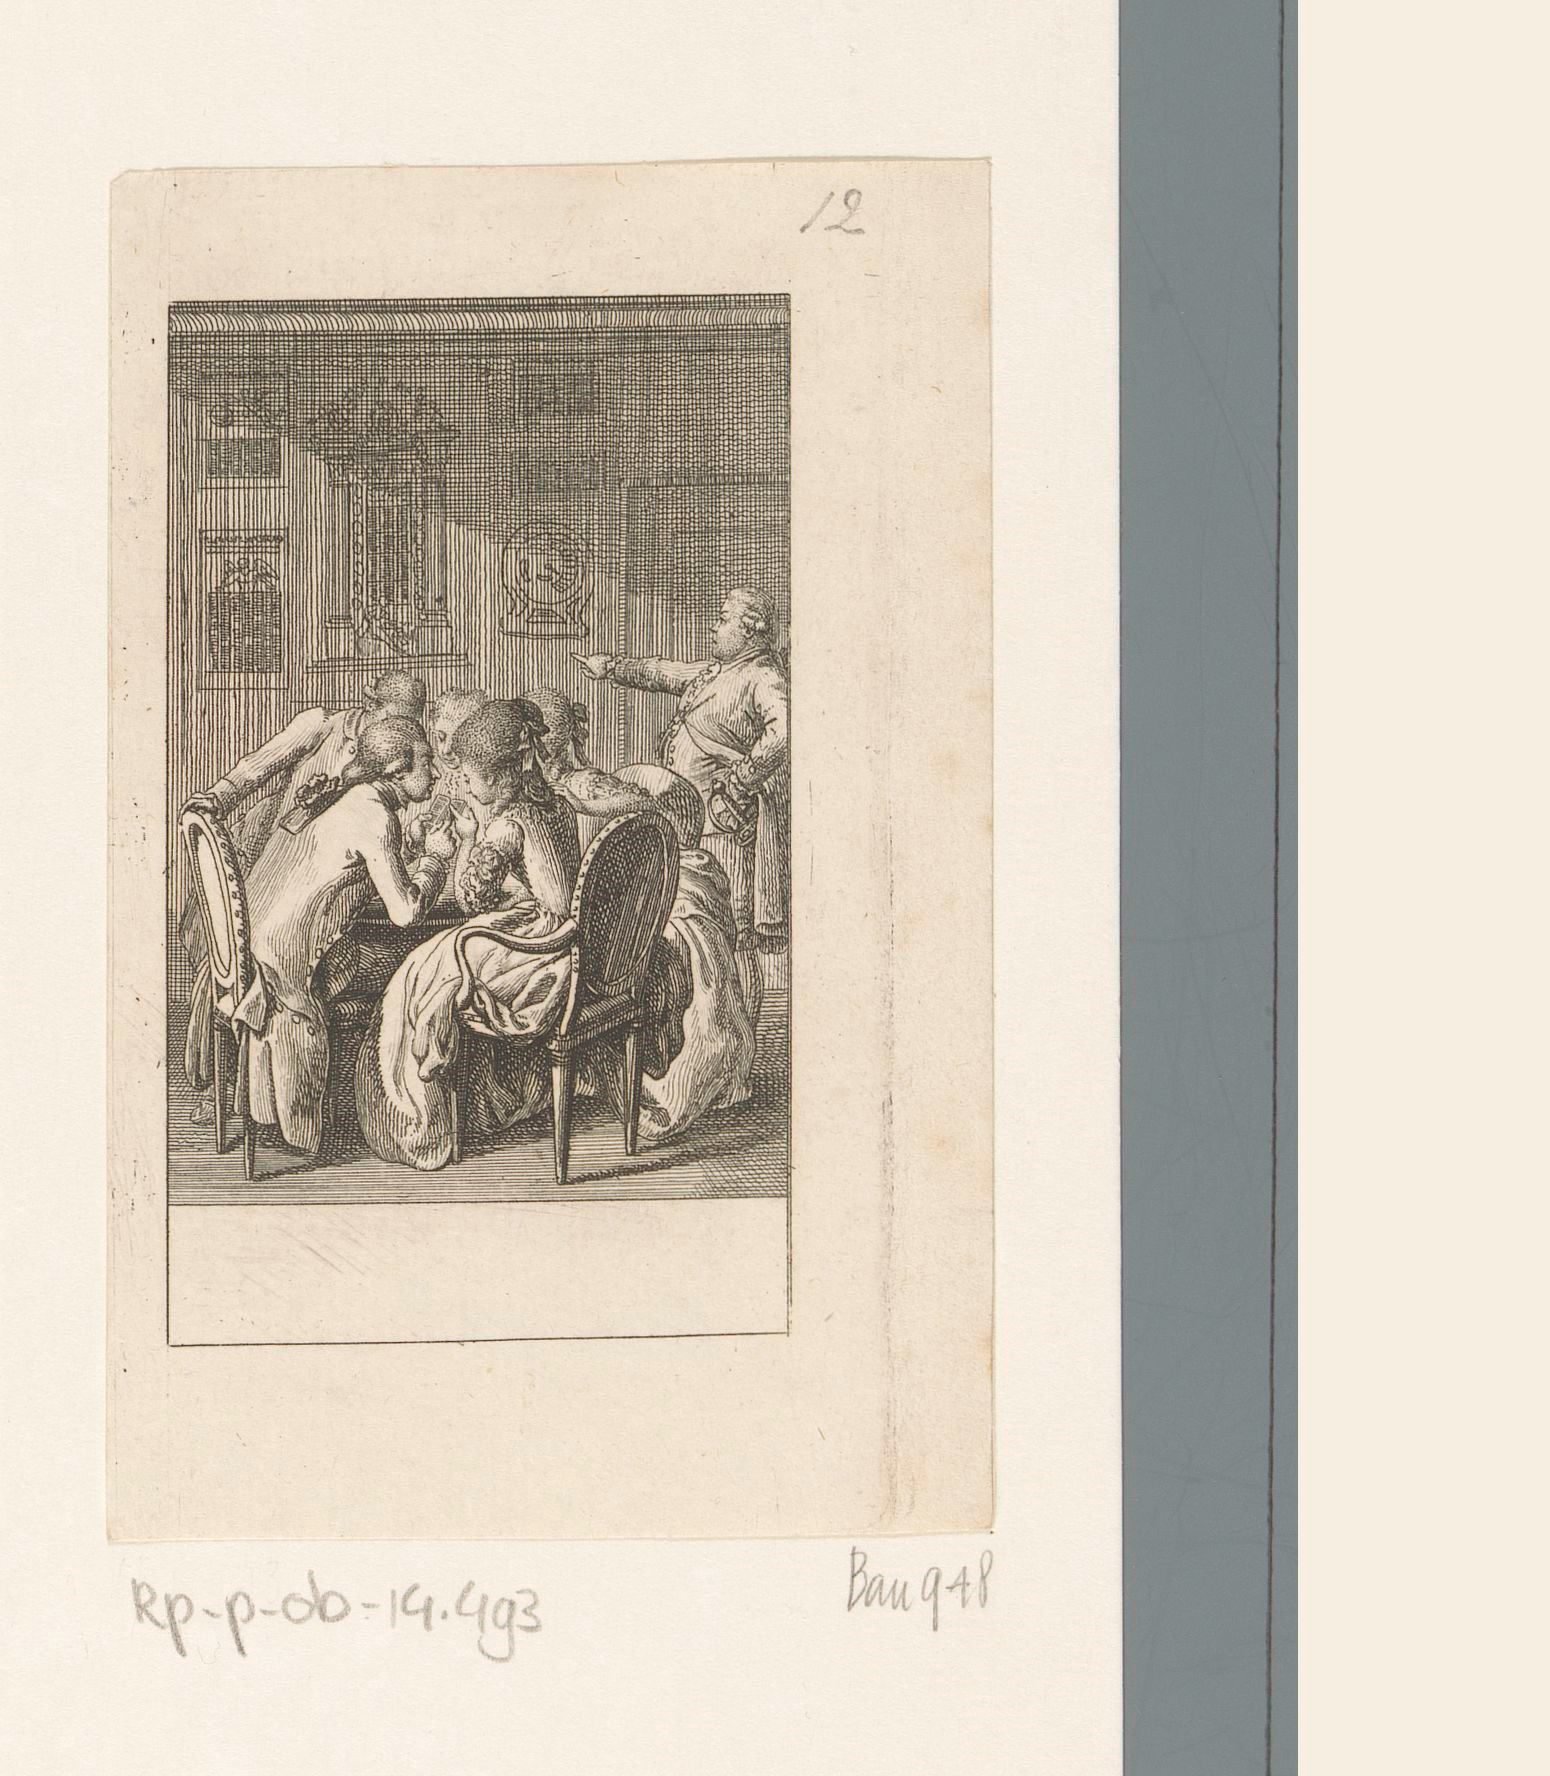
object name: print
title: Dwaasheid van het vertrouwen op almanakken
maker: daniel nikolaus chodowiecki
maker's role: draughtsman, print maker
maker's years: 1726-1801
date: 1782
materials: paper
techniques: etching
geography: berlin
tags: calendar, almanac, folly, foolishness; 'pazzia', 'sciocchezza', 'stoltitia' (ripa)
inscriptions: collector's mark: Lugt 2228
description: Vervaardigd voor Sancta Clara's 'Centifolium Stultorum'. Latere staat gebruikt voor: Goettinger Taschen Calender vom Jahr 1783. bey Joh. Chr. Dietrich. Göttingen: Georg Christoph Lichtenberg, 1782.